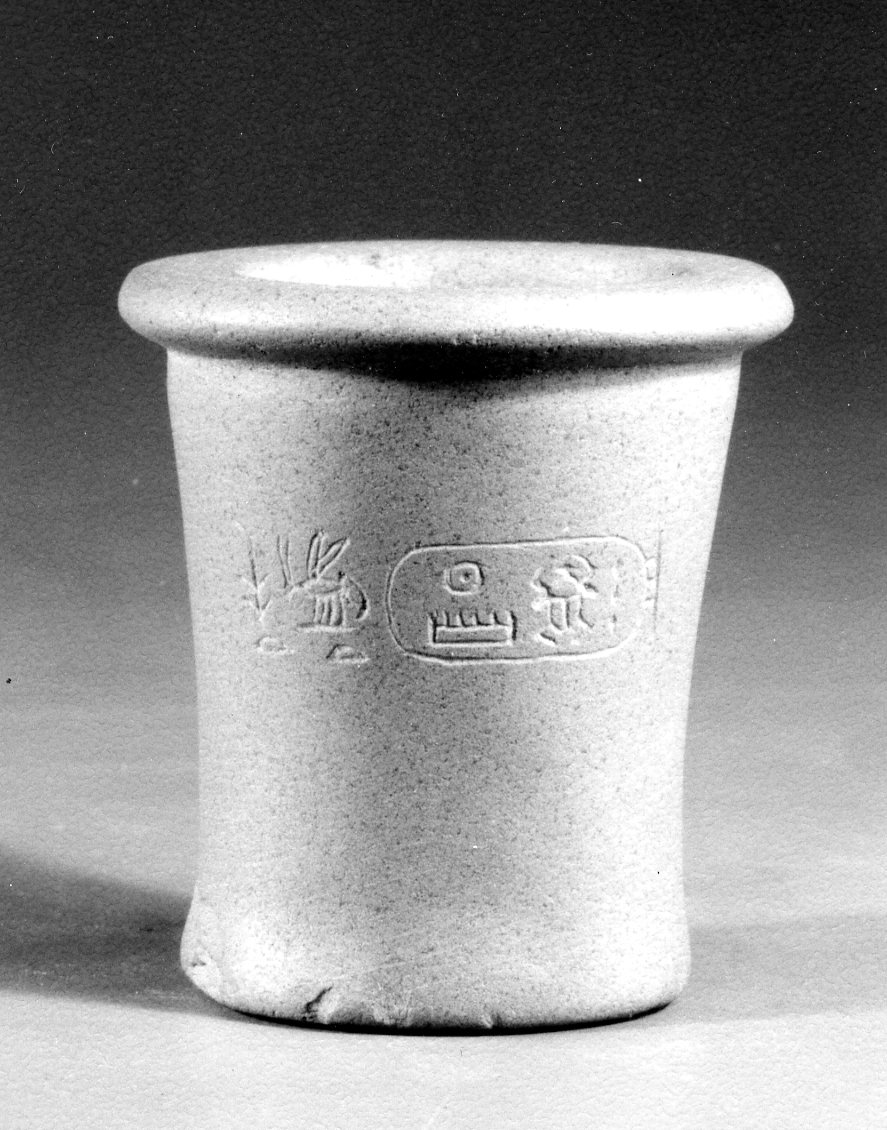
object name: ointment jar, thutmose iv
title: Ointment Jar Inscribed with the Name of Thutmose IV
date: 1400-1390 BCE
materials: wood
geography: egypt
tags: hieroglyphs